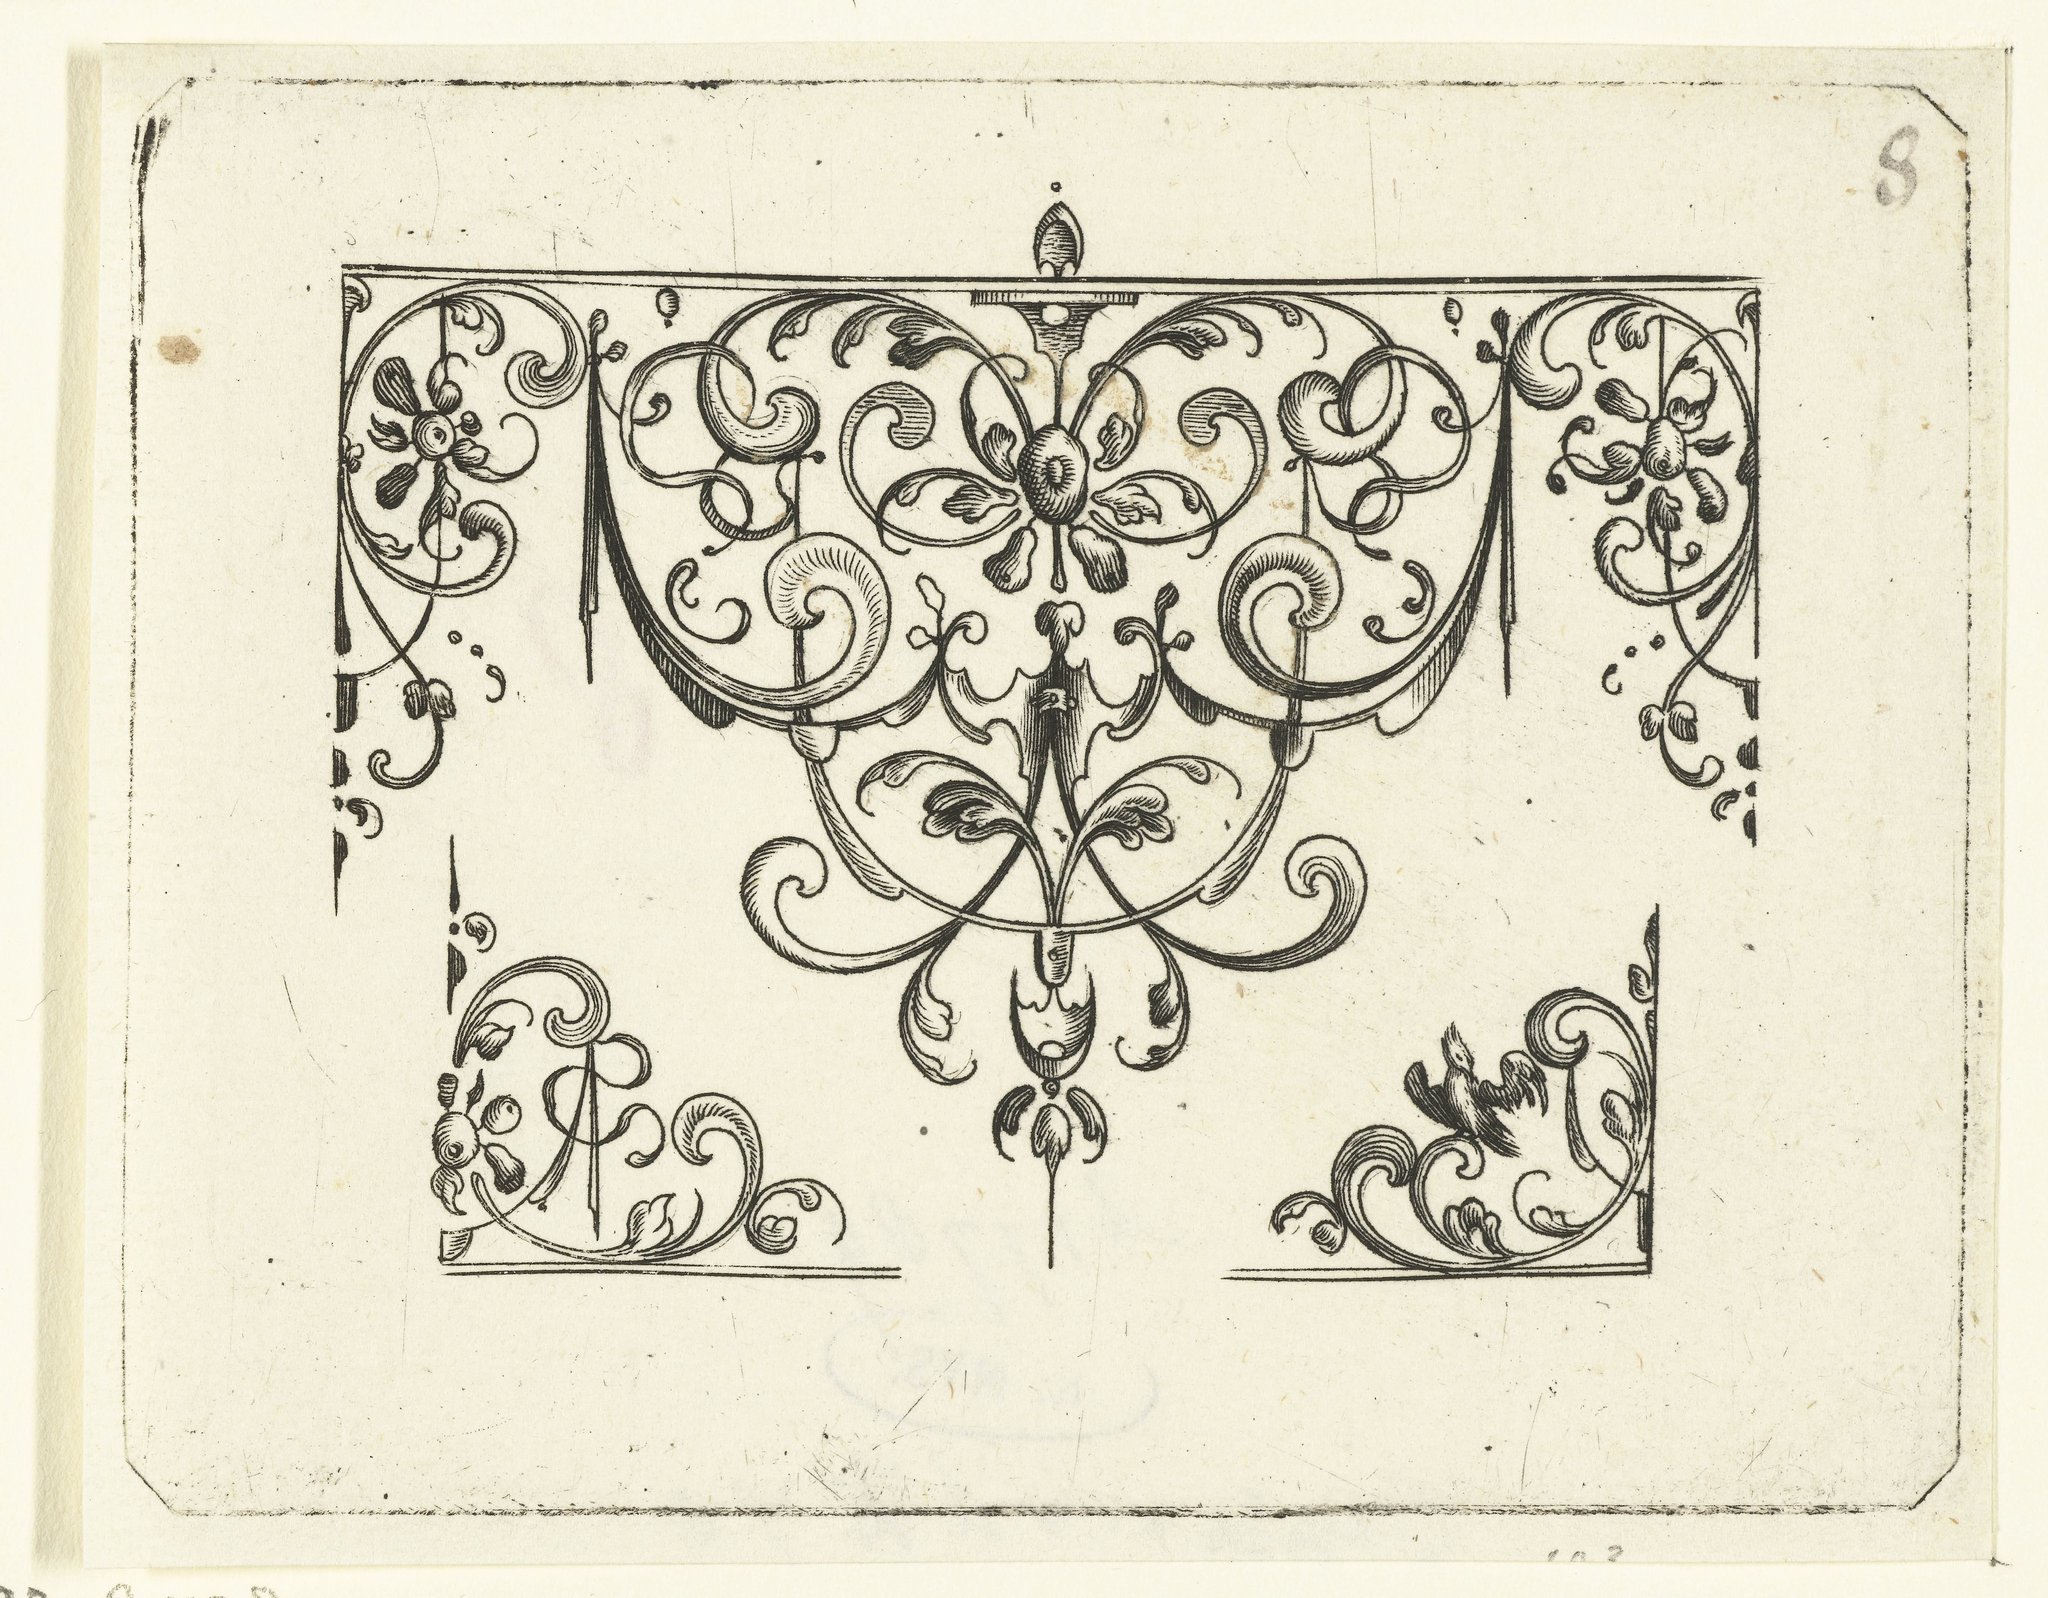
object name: ornament print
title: Somige Eenvoldige Vruchten en Spitsen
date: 1611-1635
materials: paper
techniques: engraving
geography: nuremberg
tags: fantasy ornament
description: Kopie van serie met dezelfde titel, uitgegeven door Michiel le Blon. Blad 8 uit serie van 14 bladen met voorbeelden voor gegraveerde decoratieranden van bekers in de vorm van driehoeken bestaande uit ranken, Schweifwerk, guirlandes met putti, dieren, vogels en maskers.